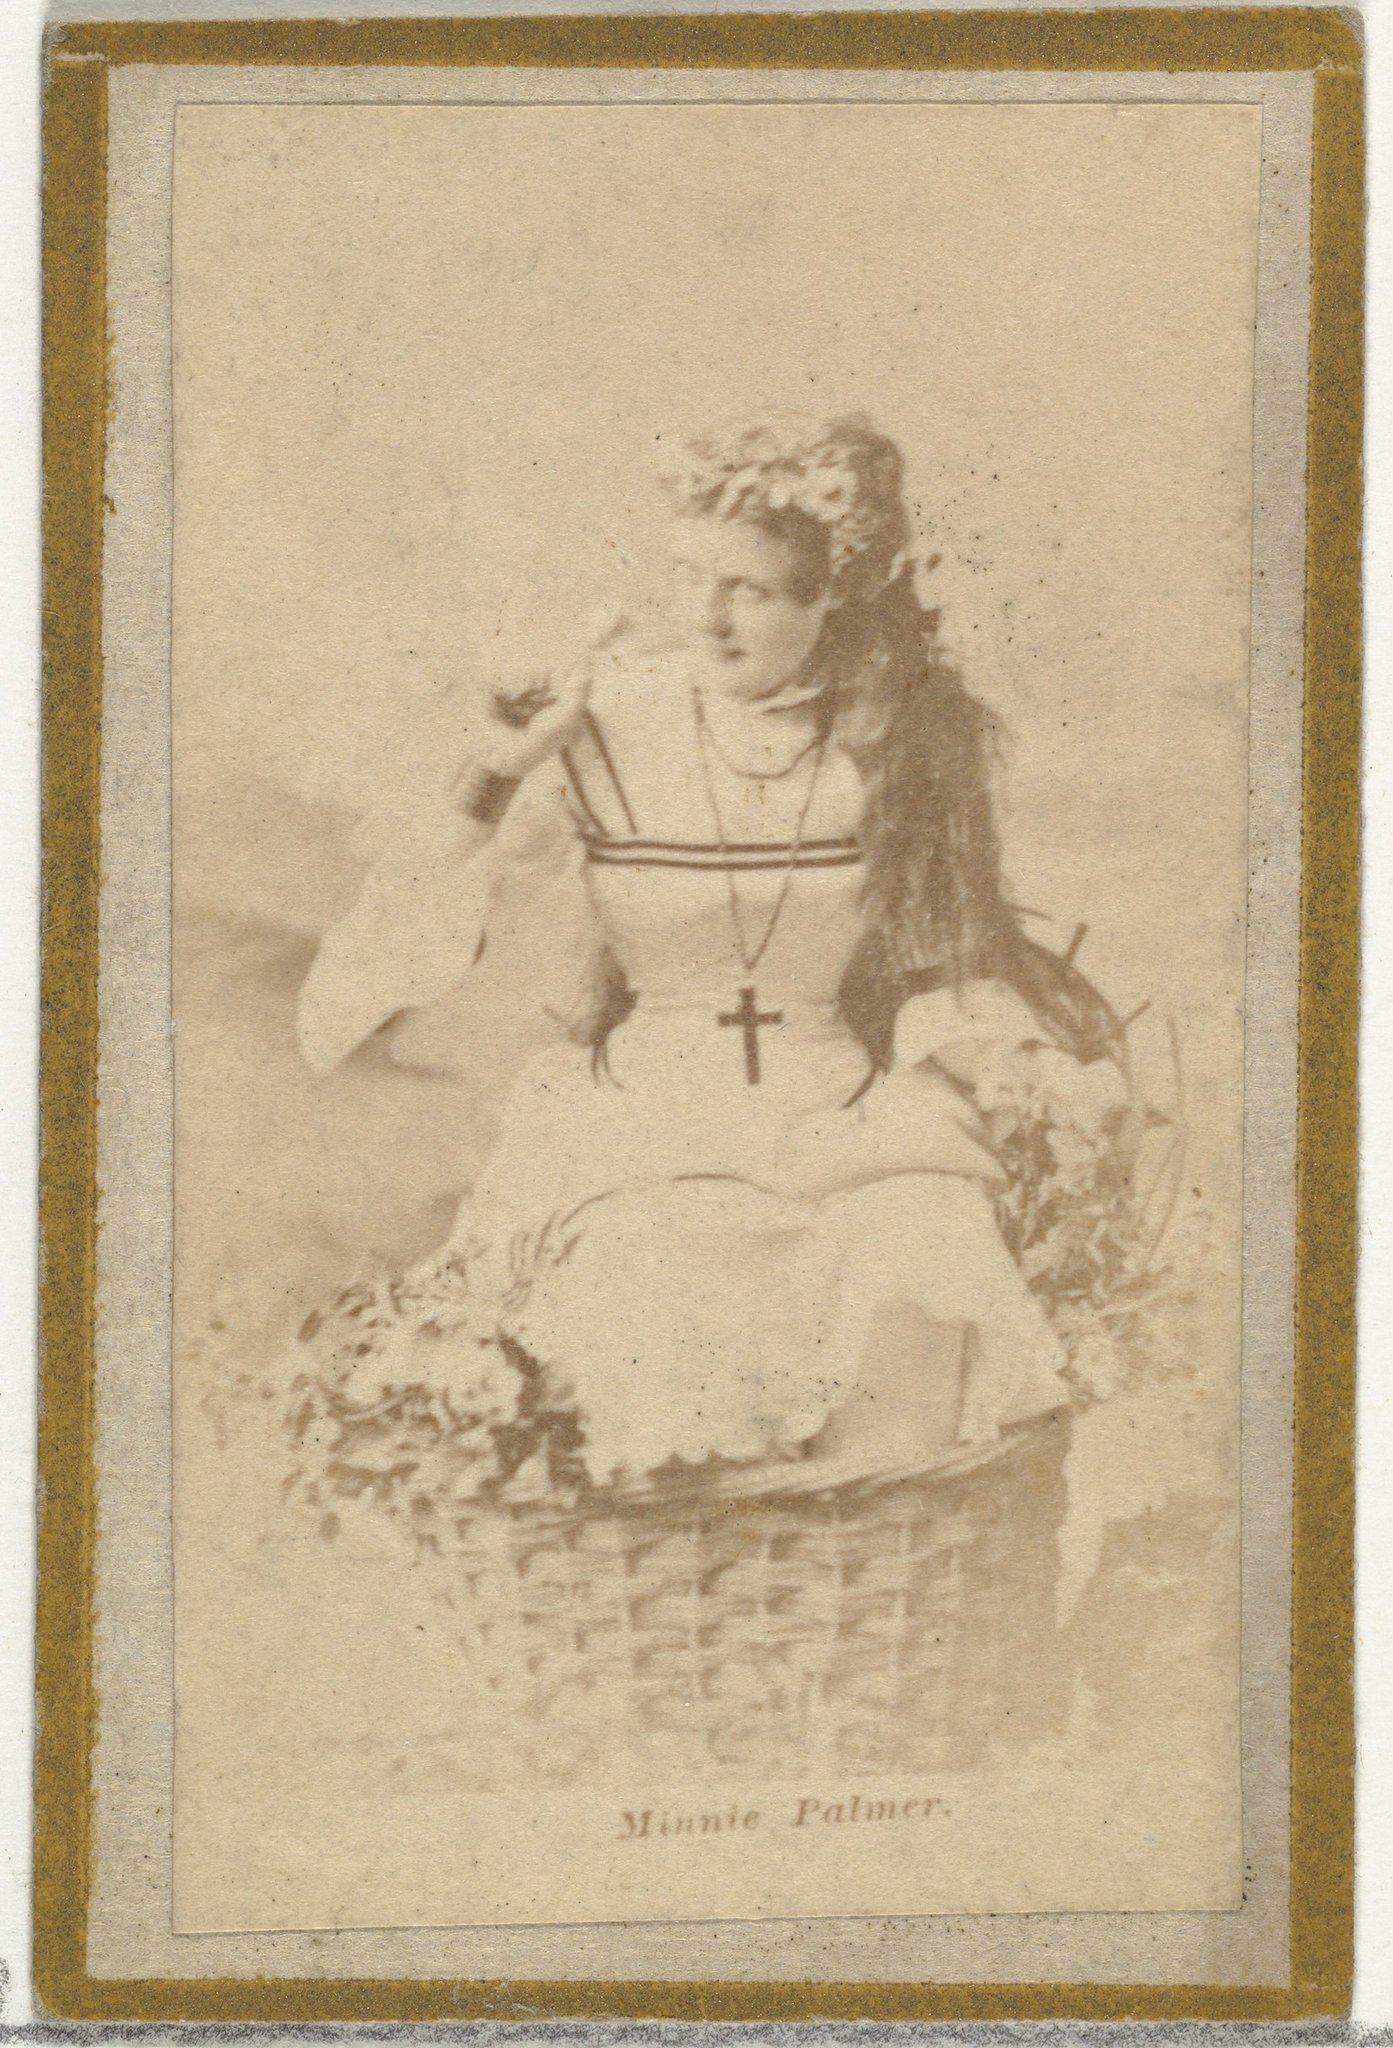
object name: photograph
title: Minnie Palmer, from the Actresses and Celebrities series (N60, Type 2) promoting Little Beauties Cigarettes for Allen & Ginter brand tobacco products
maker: allen & ginter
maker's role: publisher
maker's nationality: american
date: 1887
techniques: albumen silver print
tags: portraits,women,actresses